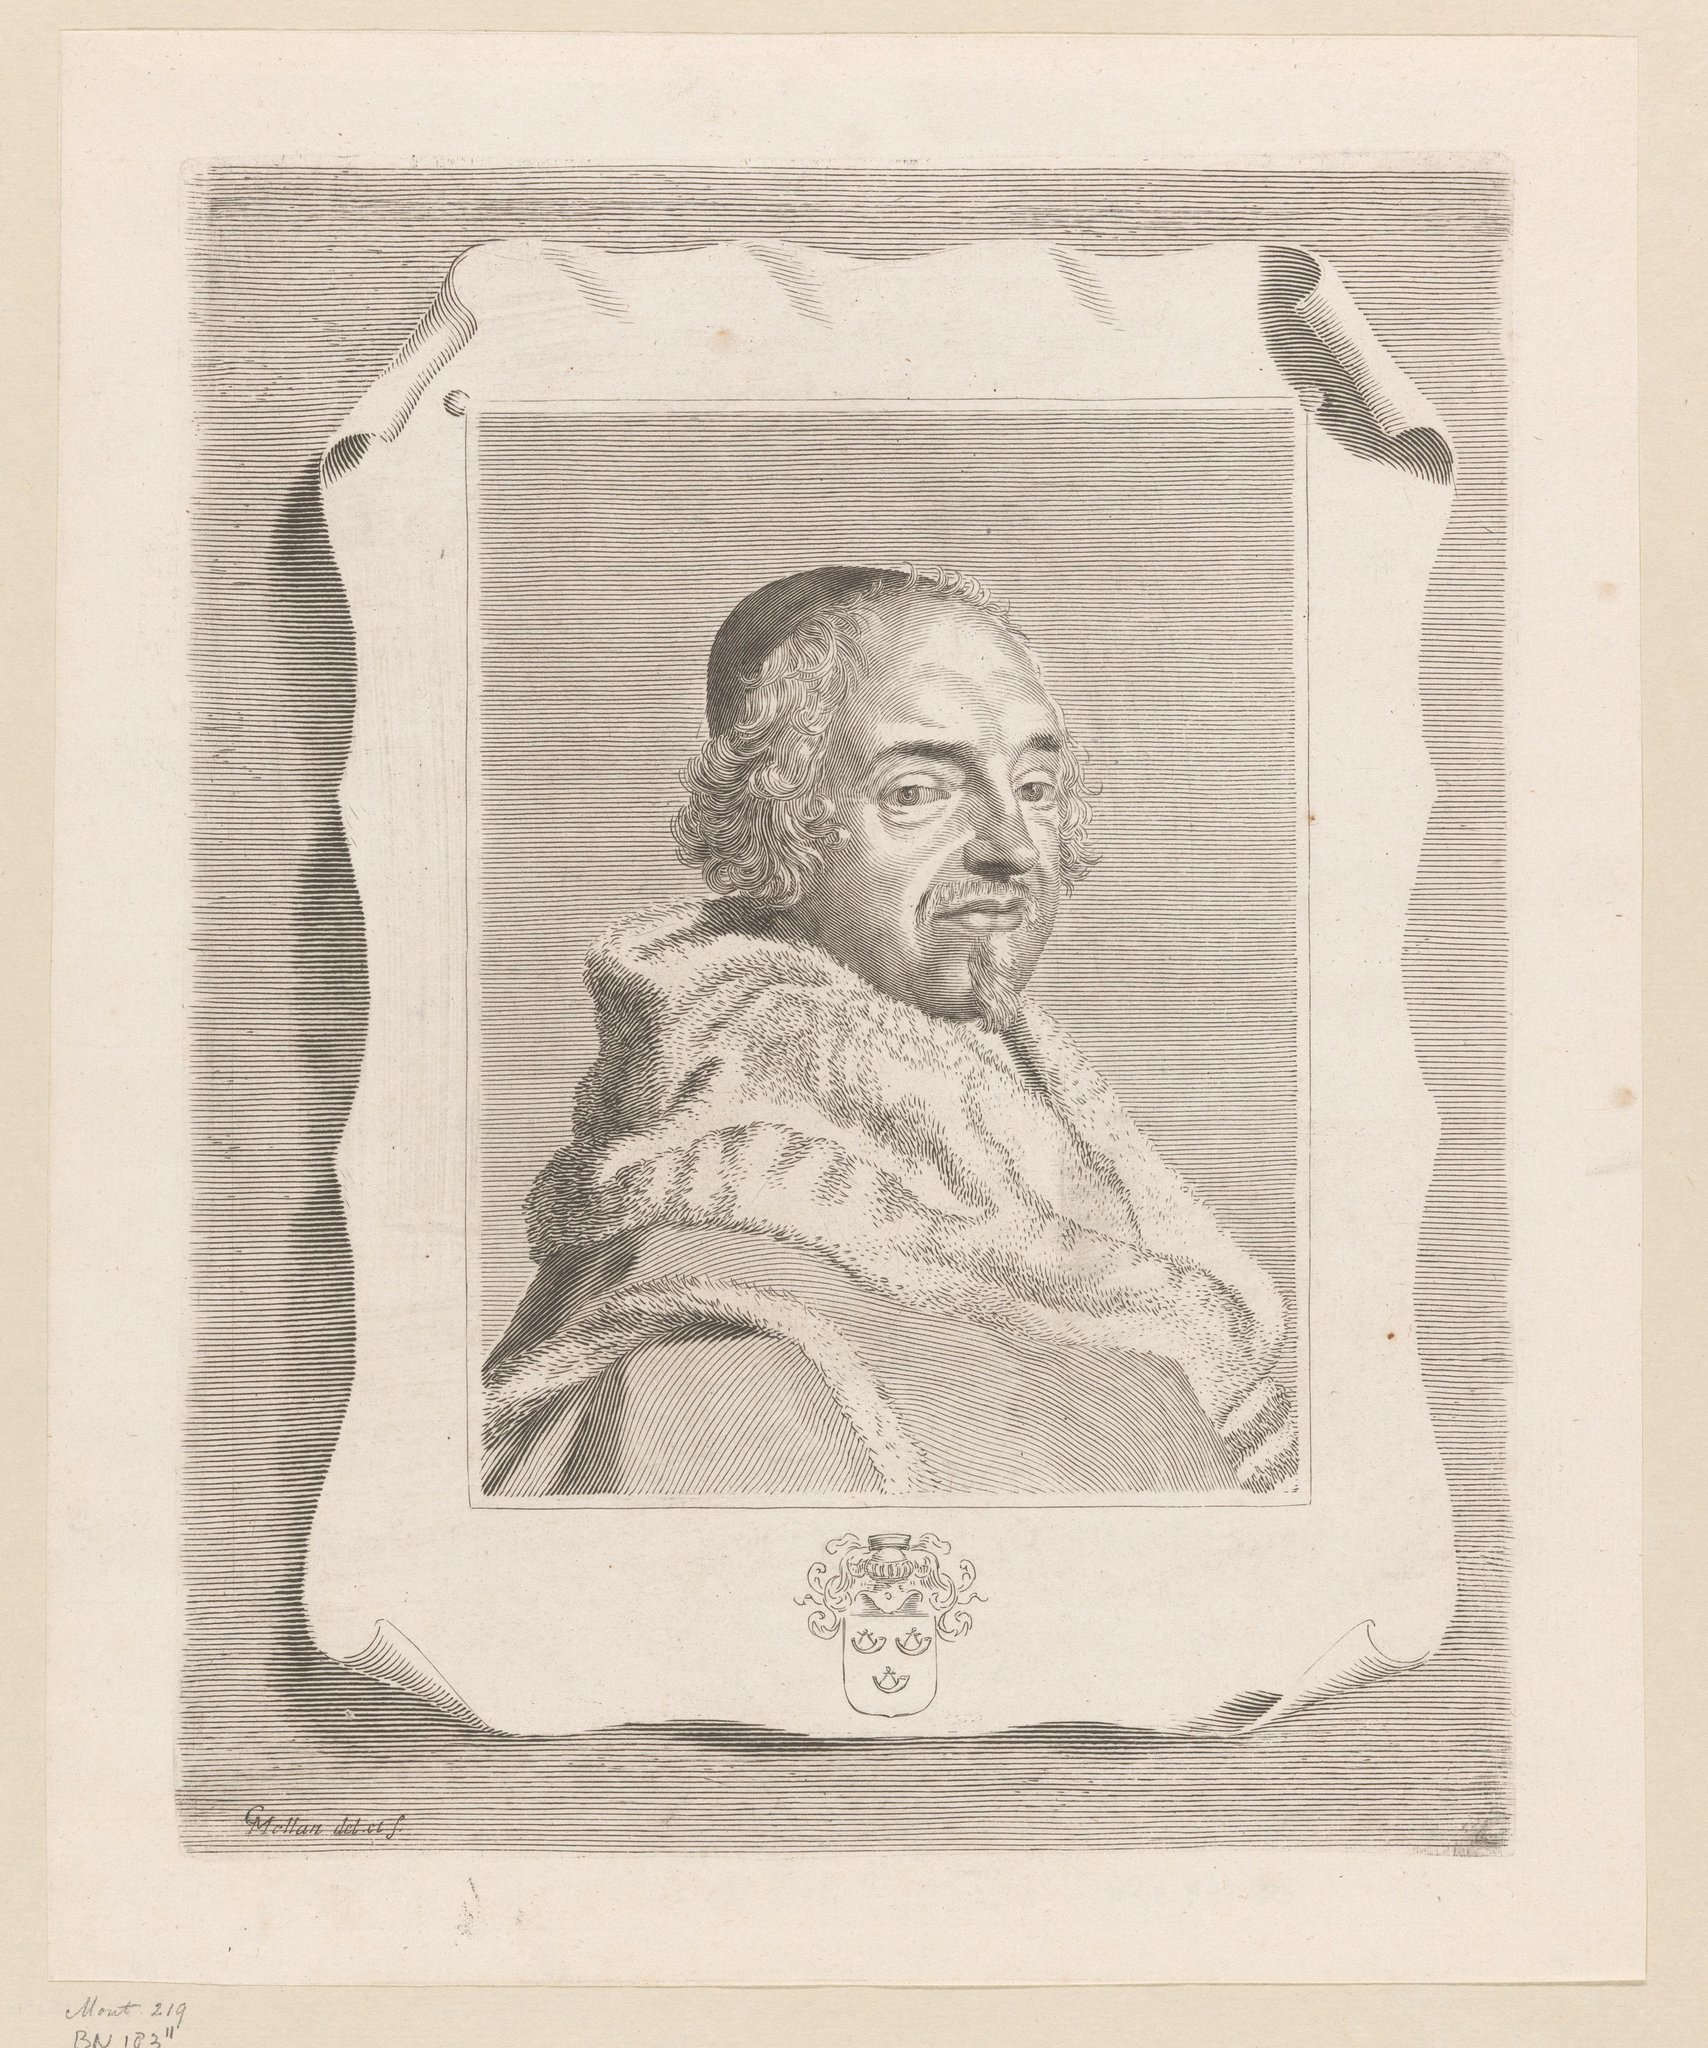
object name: print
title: Portret van François-Théodore de Nesmond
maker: claude mellan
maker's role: draughtsman, print maker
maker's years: 1598-1688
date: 1640-1644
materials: paper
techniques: engraving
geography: france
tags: historical persons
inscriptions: watermark, collector's mark: Lugt 240